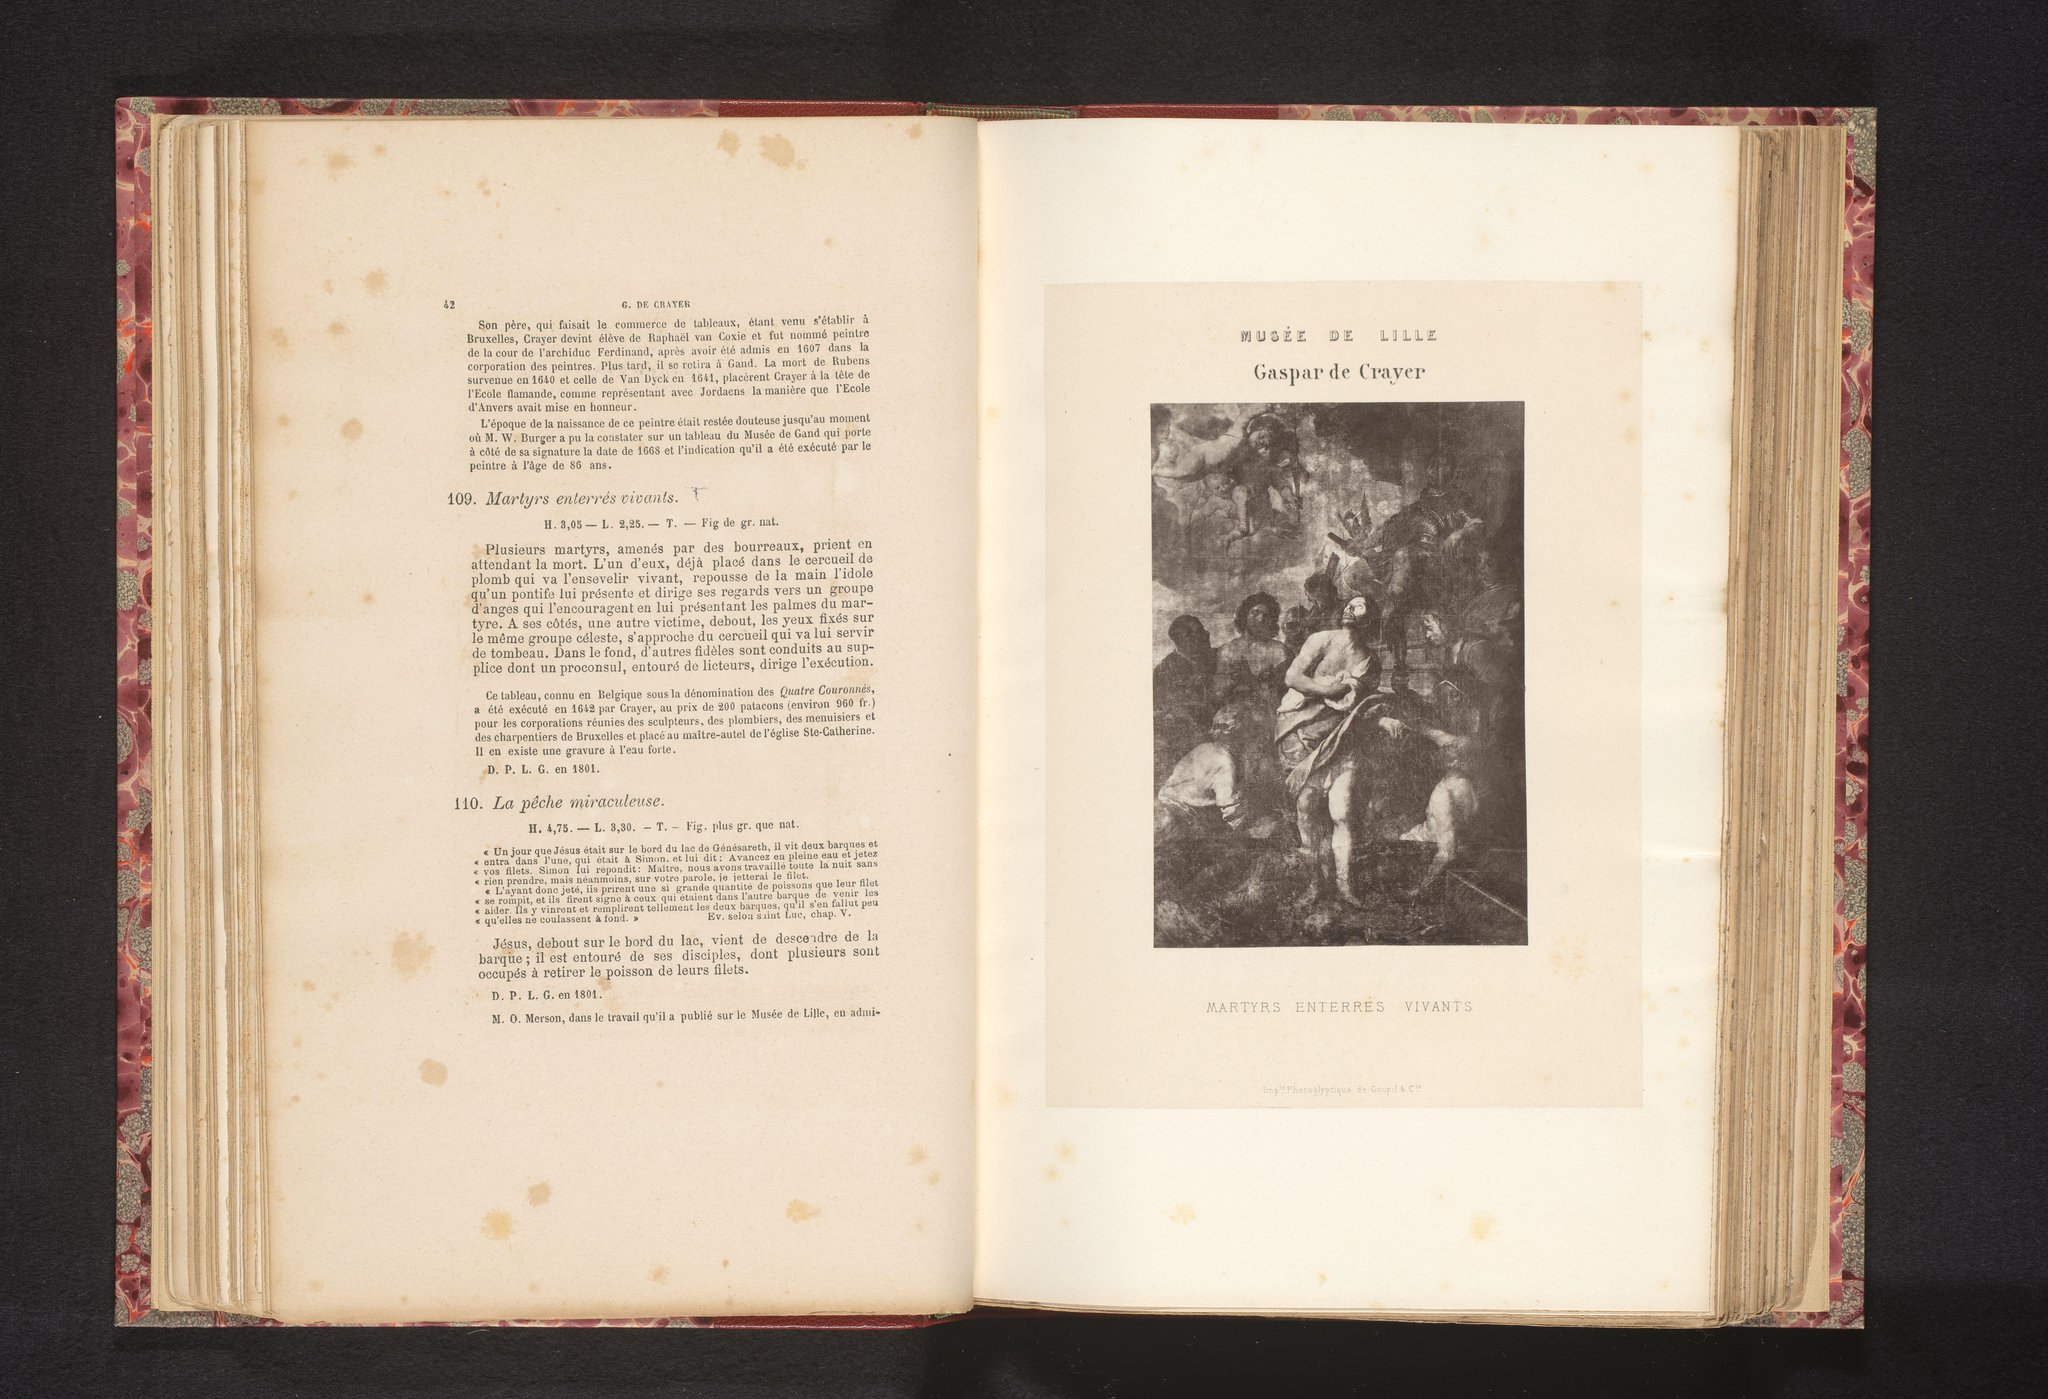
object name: photomechanical print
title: Martyrs enterrés vivants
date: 1862-1872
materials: paper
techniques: woodburytype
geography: lille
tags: martyr(s) (often with palm-branches)